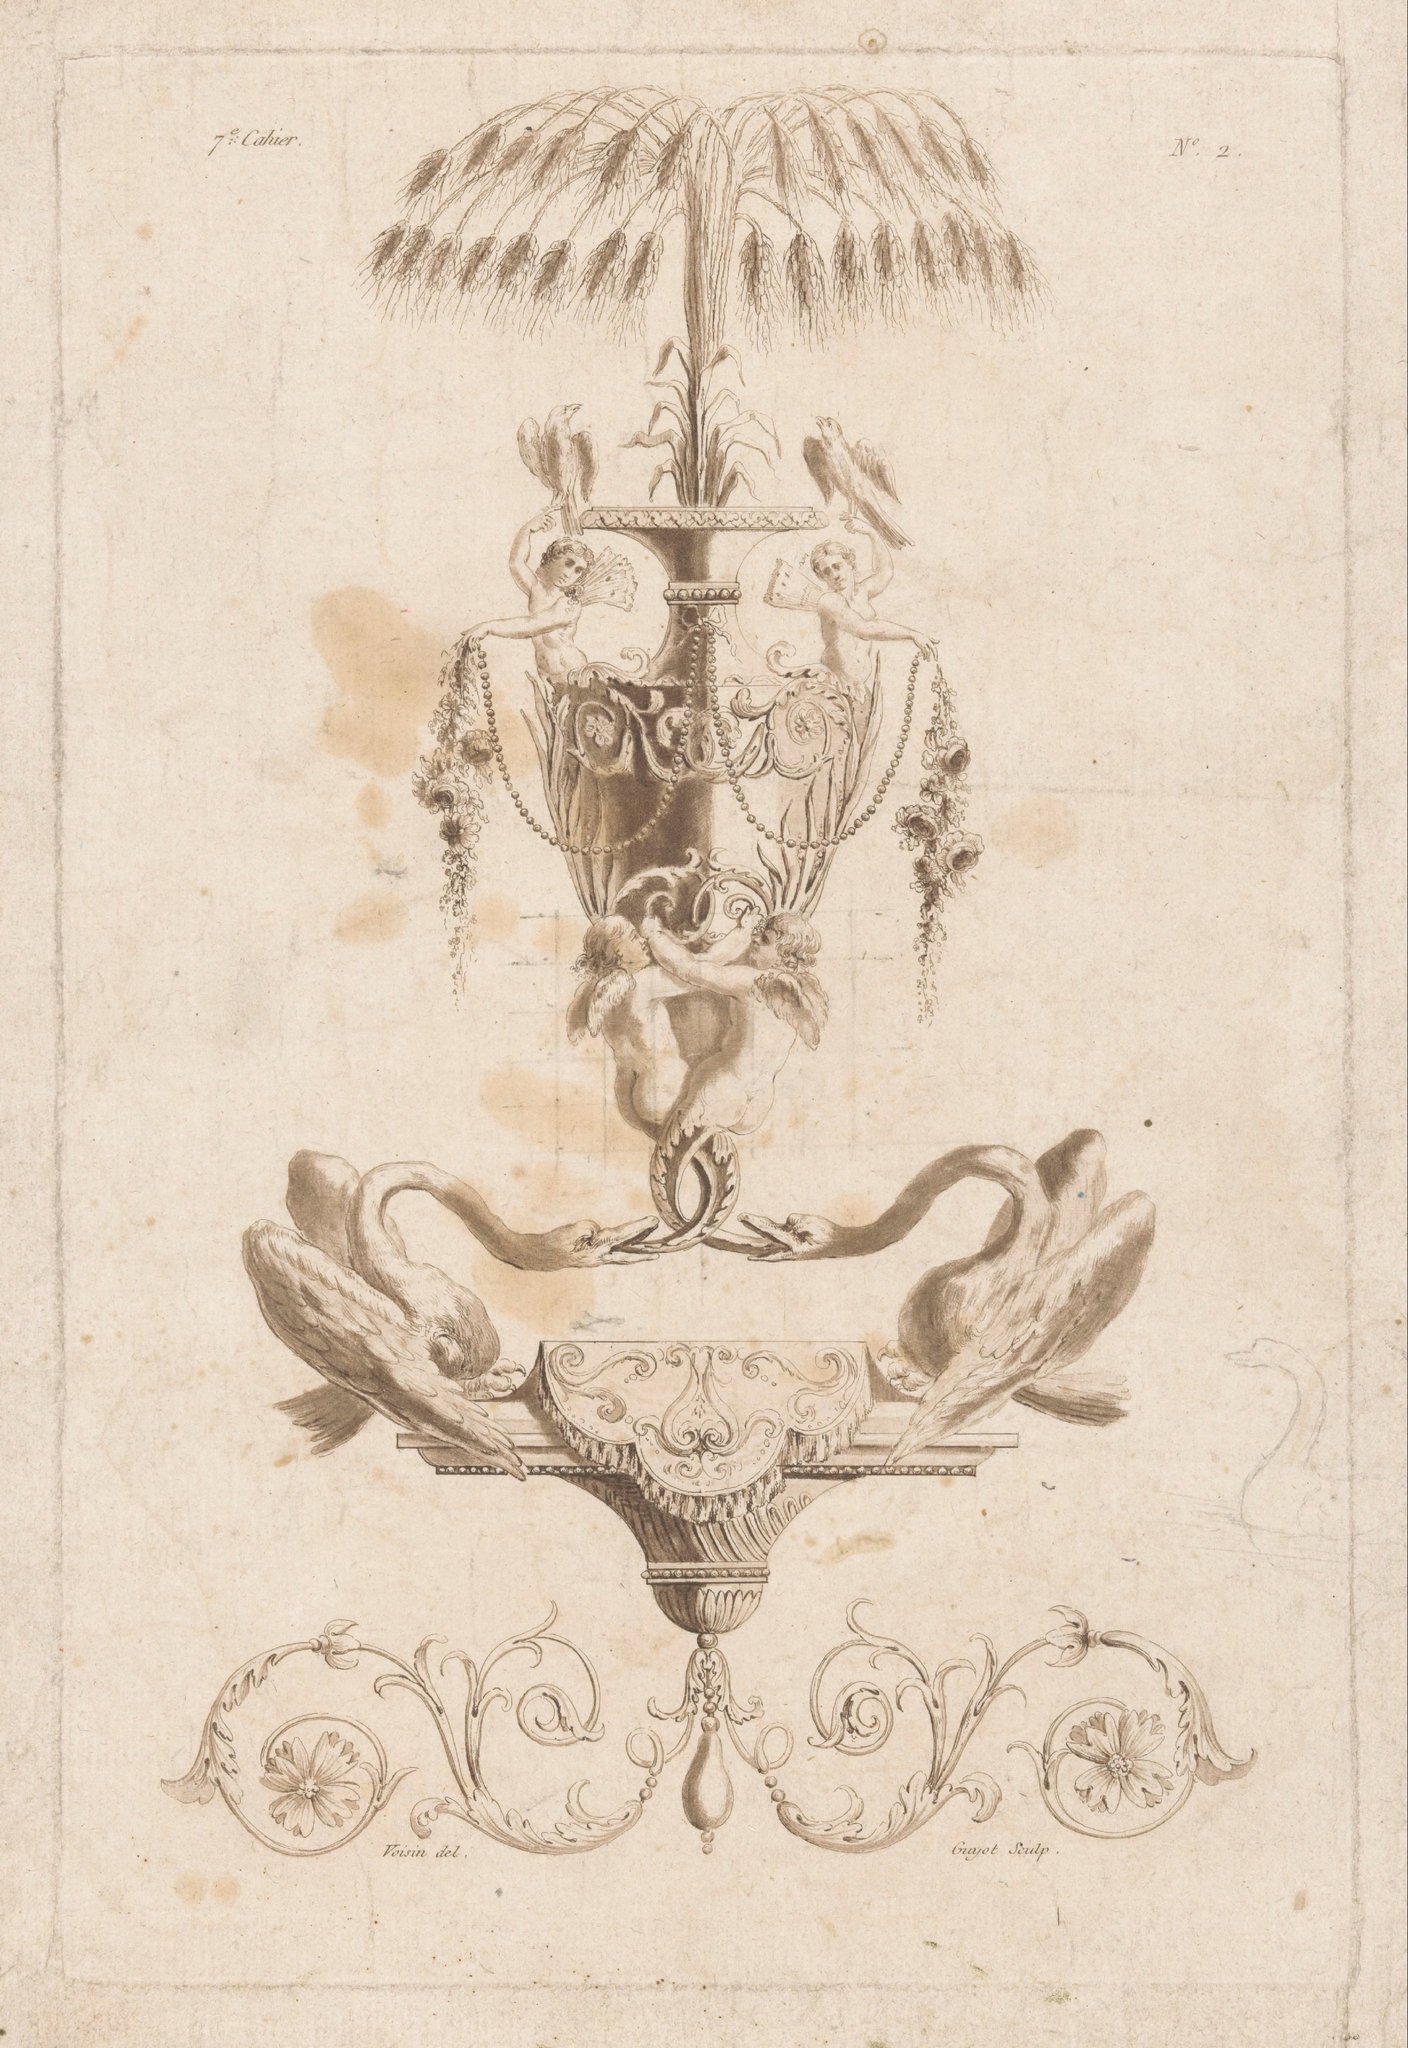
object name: ornament print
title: 7e Cahier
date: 1788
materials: paper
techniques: aquatint, etching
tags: water-birds: swan, vase ~ ornament, cupids: 'amores', 'amoretti', 'putti'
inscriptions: collector's mark: Lugt 2228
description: Een geornamenteerde vaas met putti, guirlandes, vogels en aren. Daaronder twee zwanen op een voetstuk en arabesken.